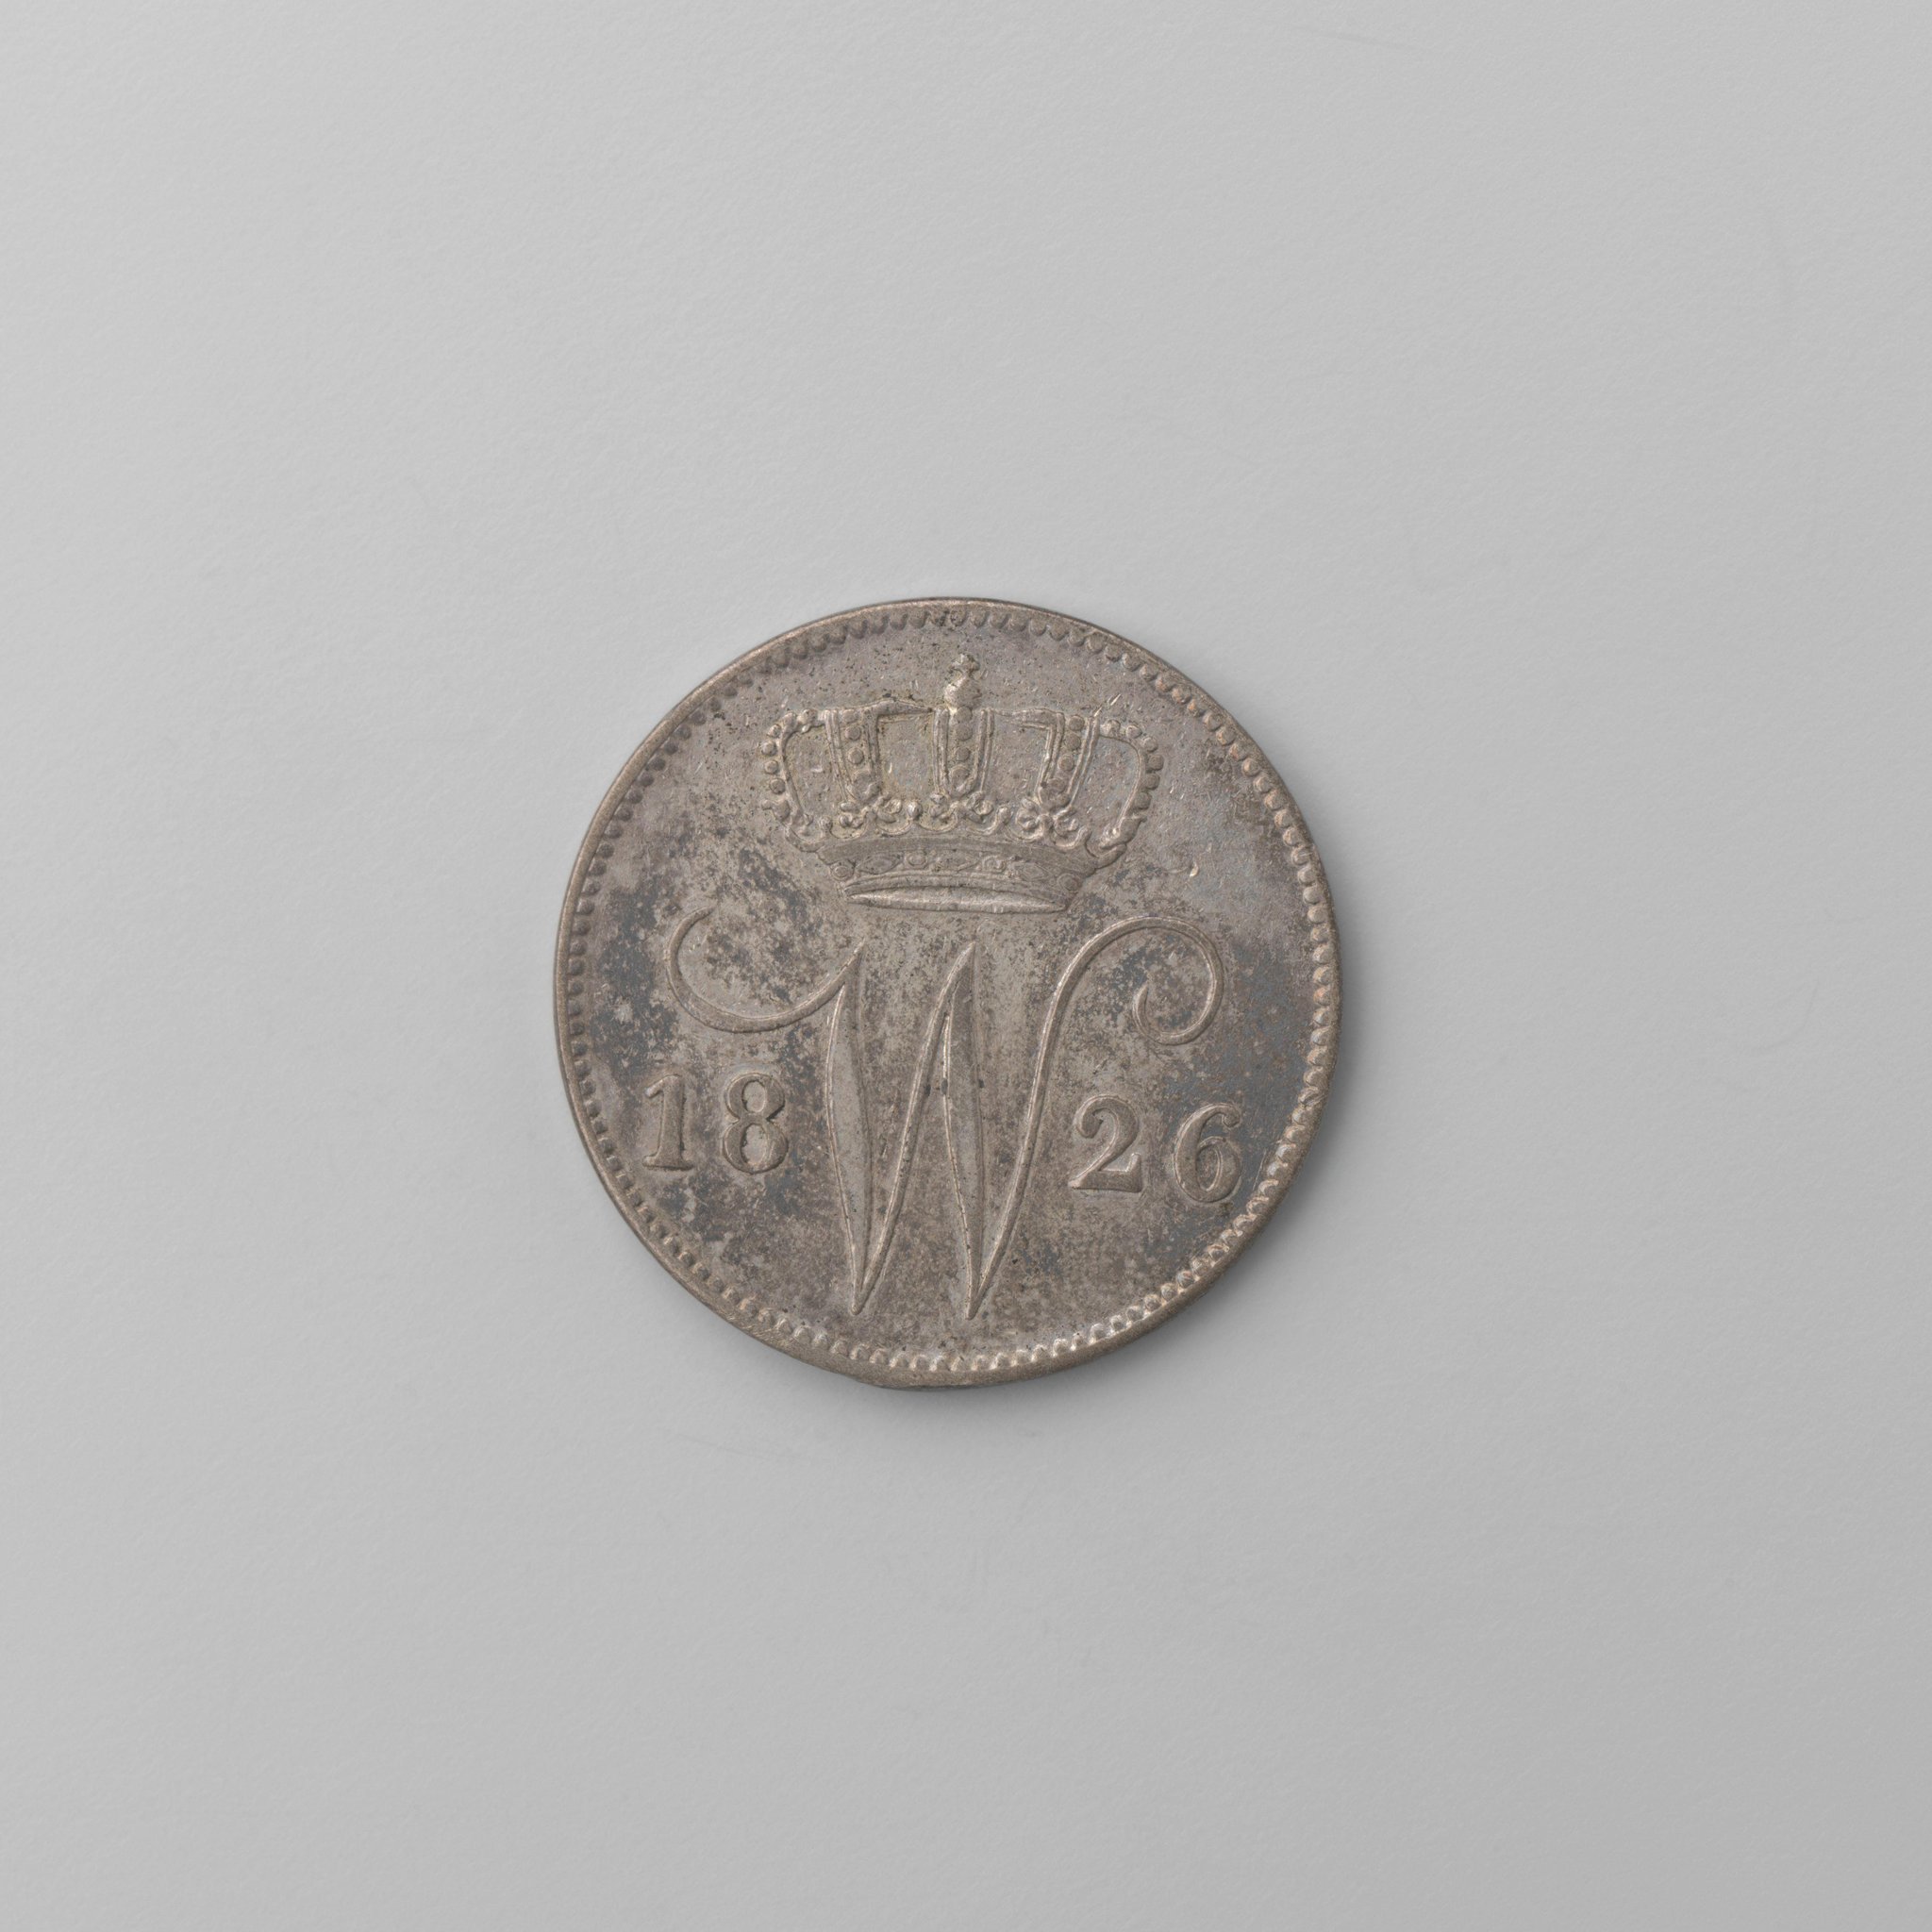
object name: coin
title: Nederland, 25 cent, 1826 Utrecht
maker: william i of the netherlands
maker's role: koning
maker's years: 1772-1843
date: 1826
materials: silver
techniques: striking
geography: utrecht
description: Zilveren munt. Voorzijde: tussen jaartal gekroonde cursieve letter W. Keerzijde: tussen waarde-aanduiding 25 C. gekroond rijkswapenschild. Gladde rand.